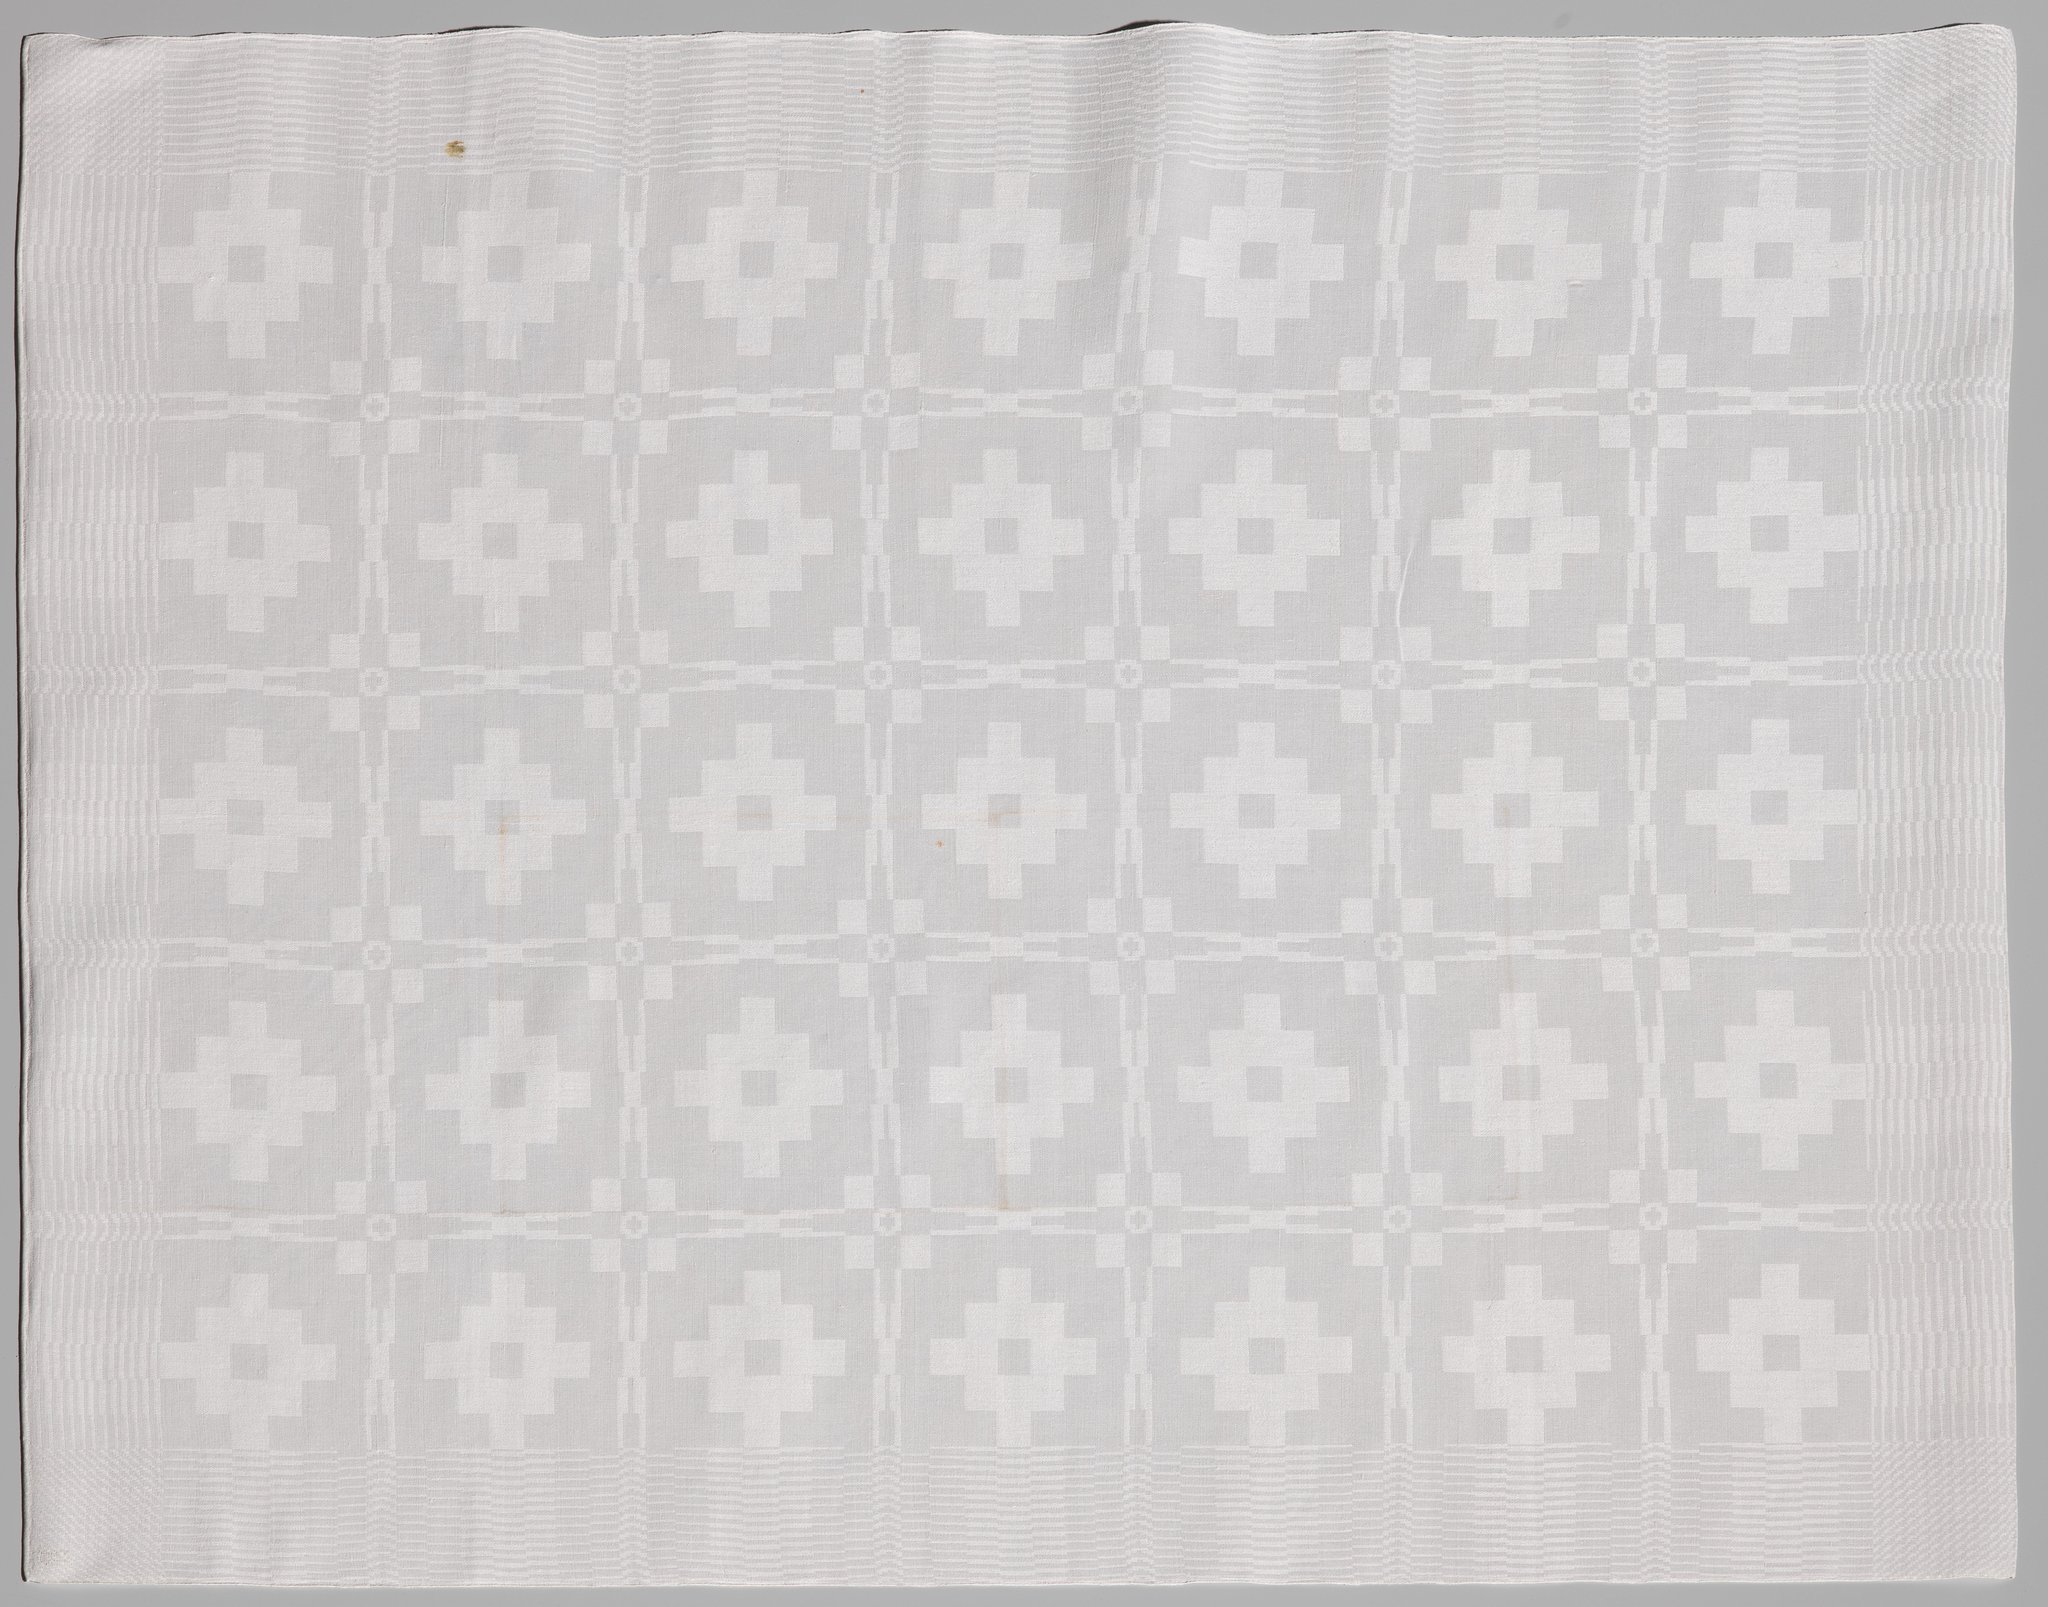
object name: napkin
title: Pellen met patroon 'uitgehouwen steen of hoekster'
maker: Anonymous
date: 1800-1899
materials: linen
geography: netherlands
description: Servet van wit linnen met pellenpatroon 'uitgehouwen steen of hoekster' en randen, merk H 13.